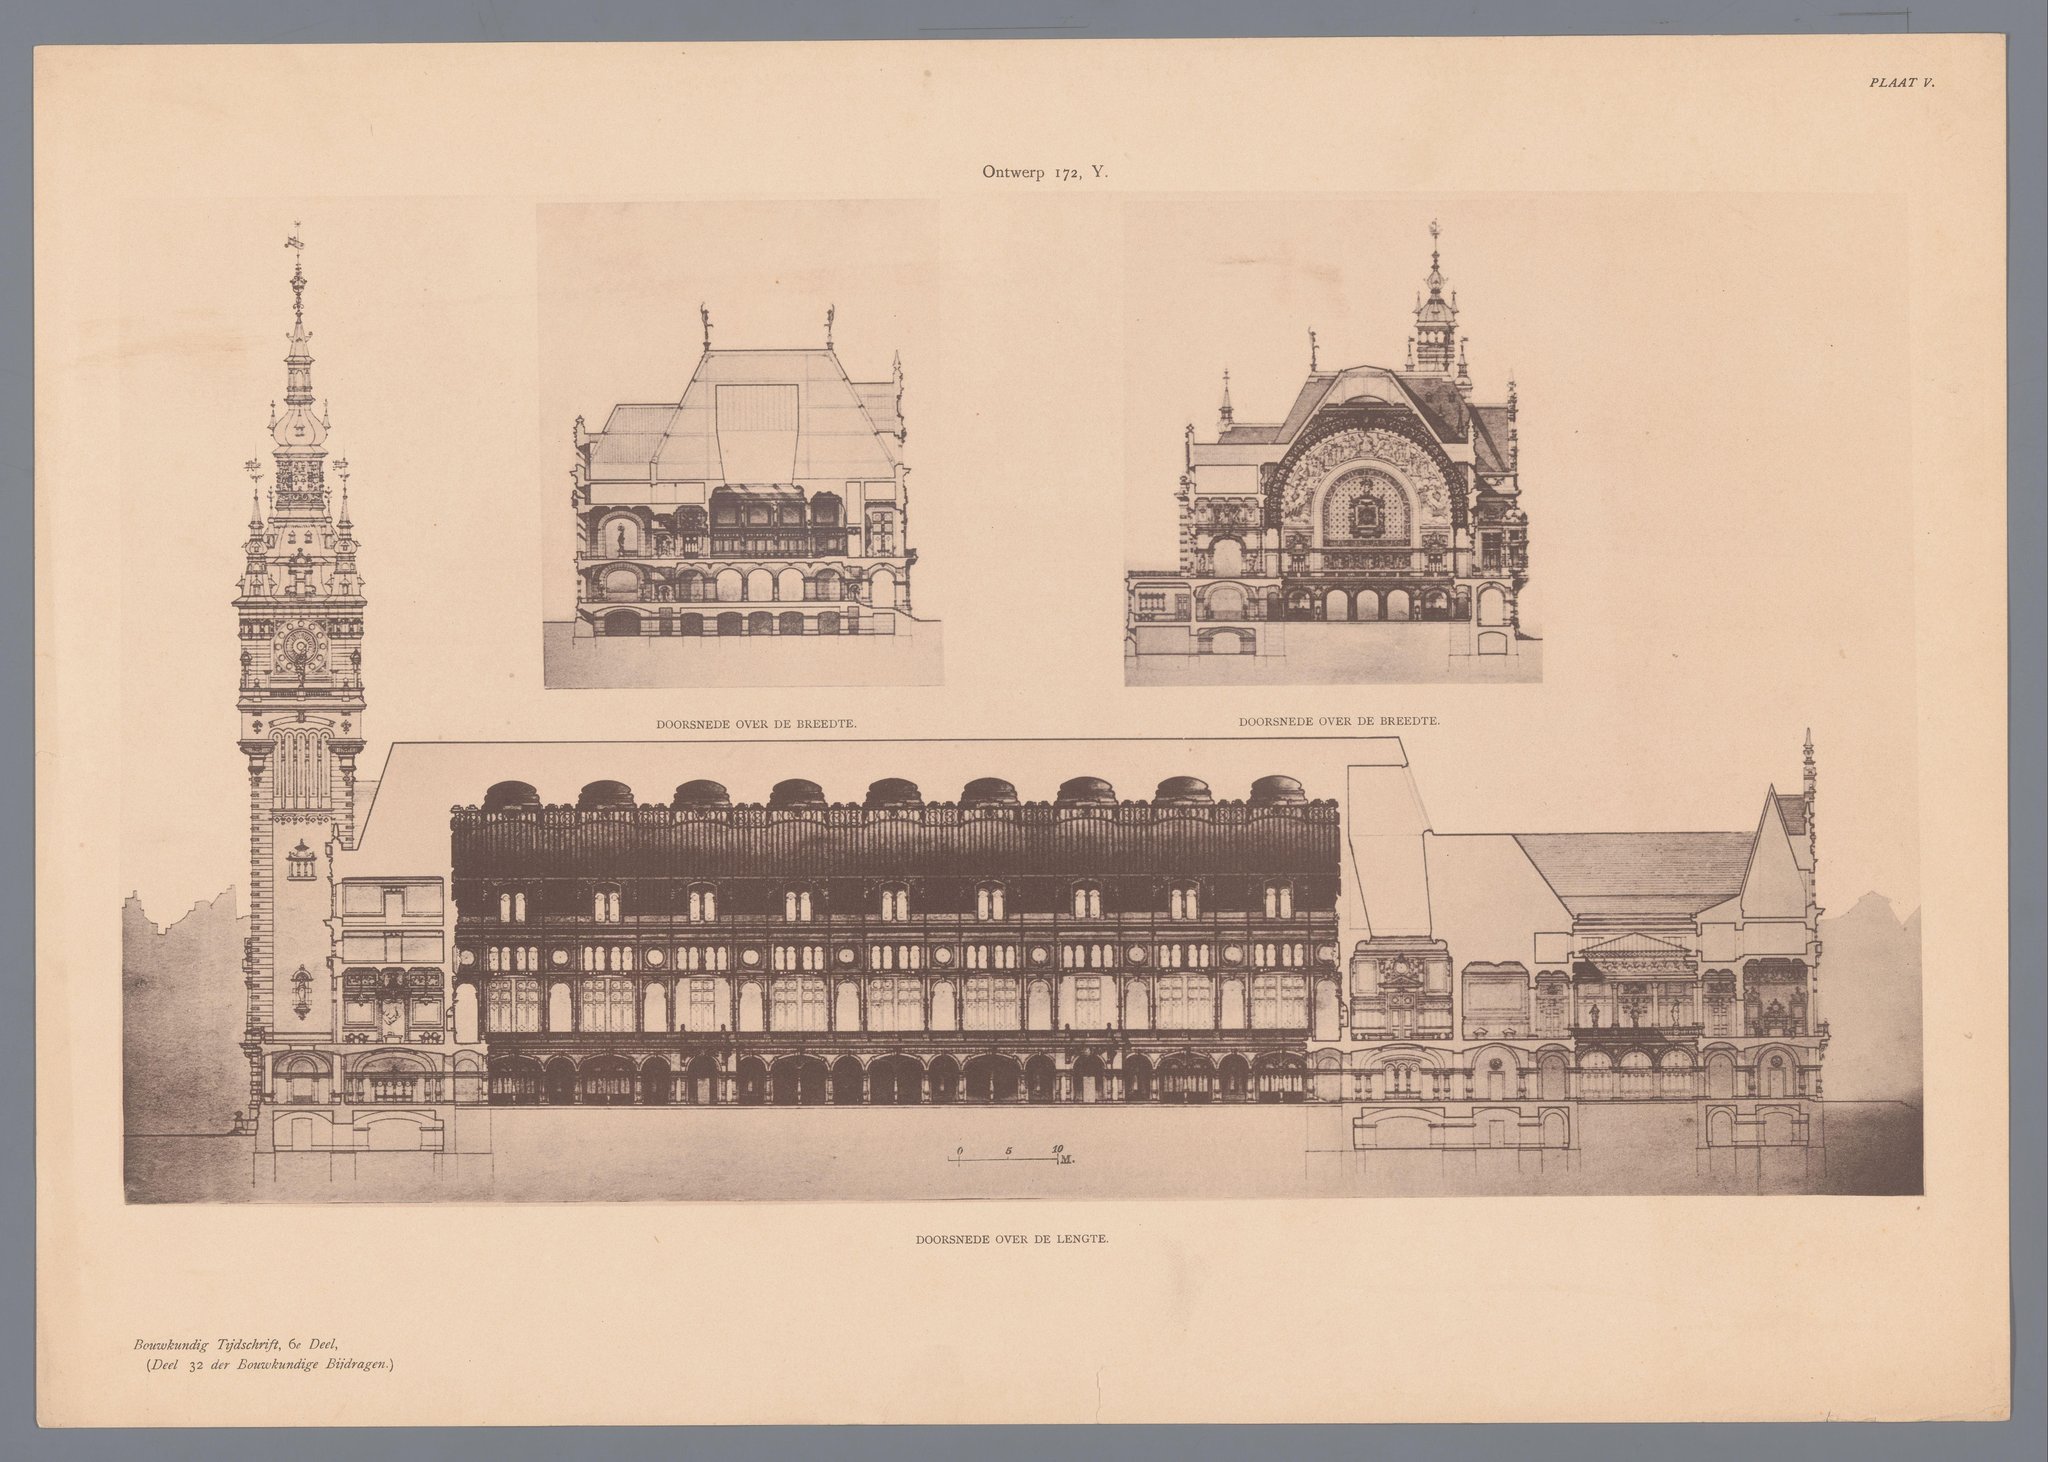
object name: photomechanical print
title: Ontwerp voor een nieuw beursgebouw in Amsterdam: doorsneden van ontwerp 172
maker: Anonymous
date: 1886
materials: paper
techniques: photograph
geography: amsterdam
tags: market-hall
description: Prent uit: Bouwkundig tijdschrift 6, deel 32 der bouwkundige bijdragen (1886), pl. 5.